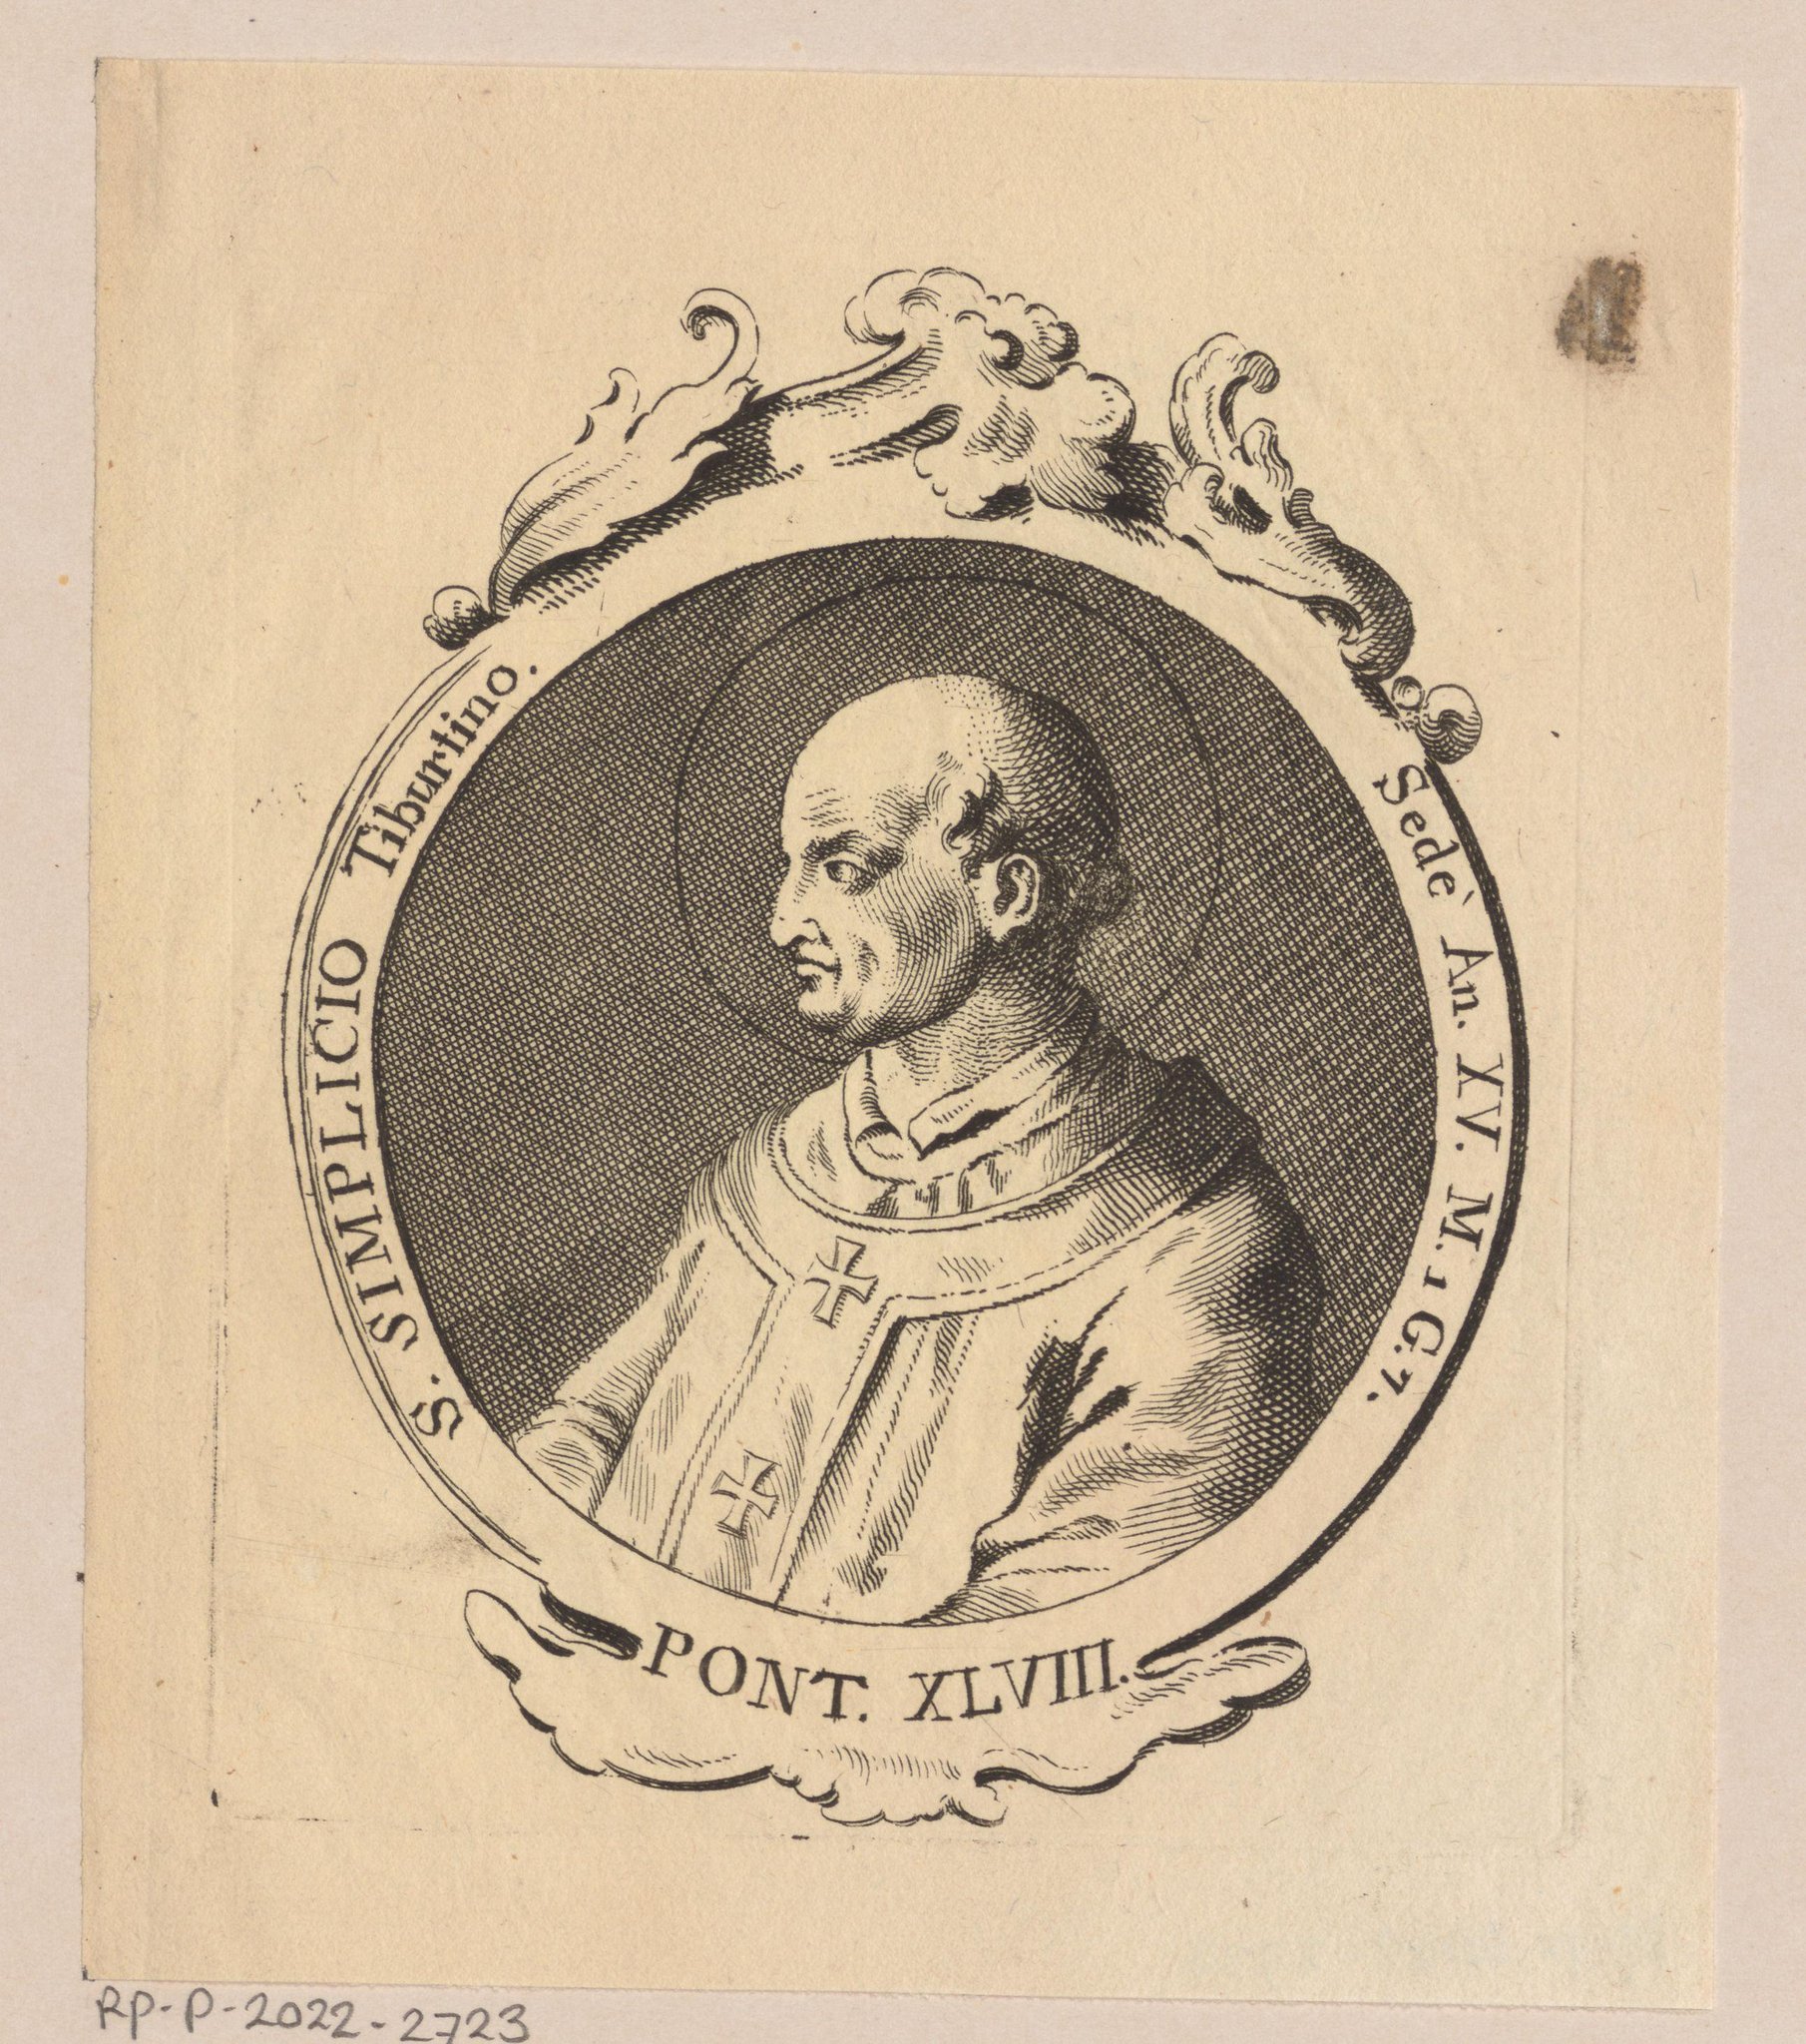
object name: print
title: Portret van Simplicius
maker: Anonymous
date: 1760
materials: paper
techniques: engraving, etching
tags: tivoli, historical persons, pope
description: Prent met tekst in boekdruk op recto en verso gebruikt in: Platina, Bartholomeo. Storia delle vite de' Pontefici (...). Venetië: Domenico Ferrarin, 1760.